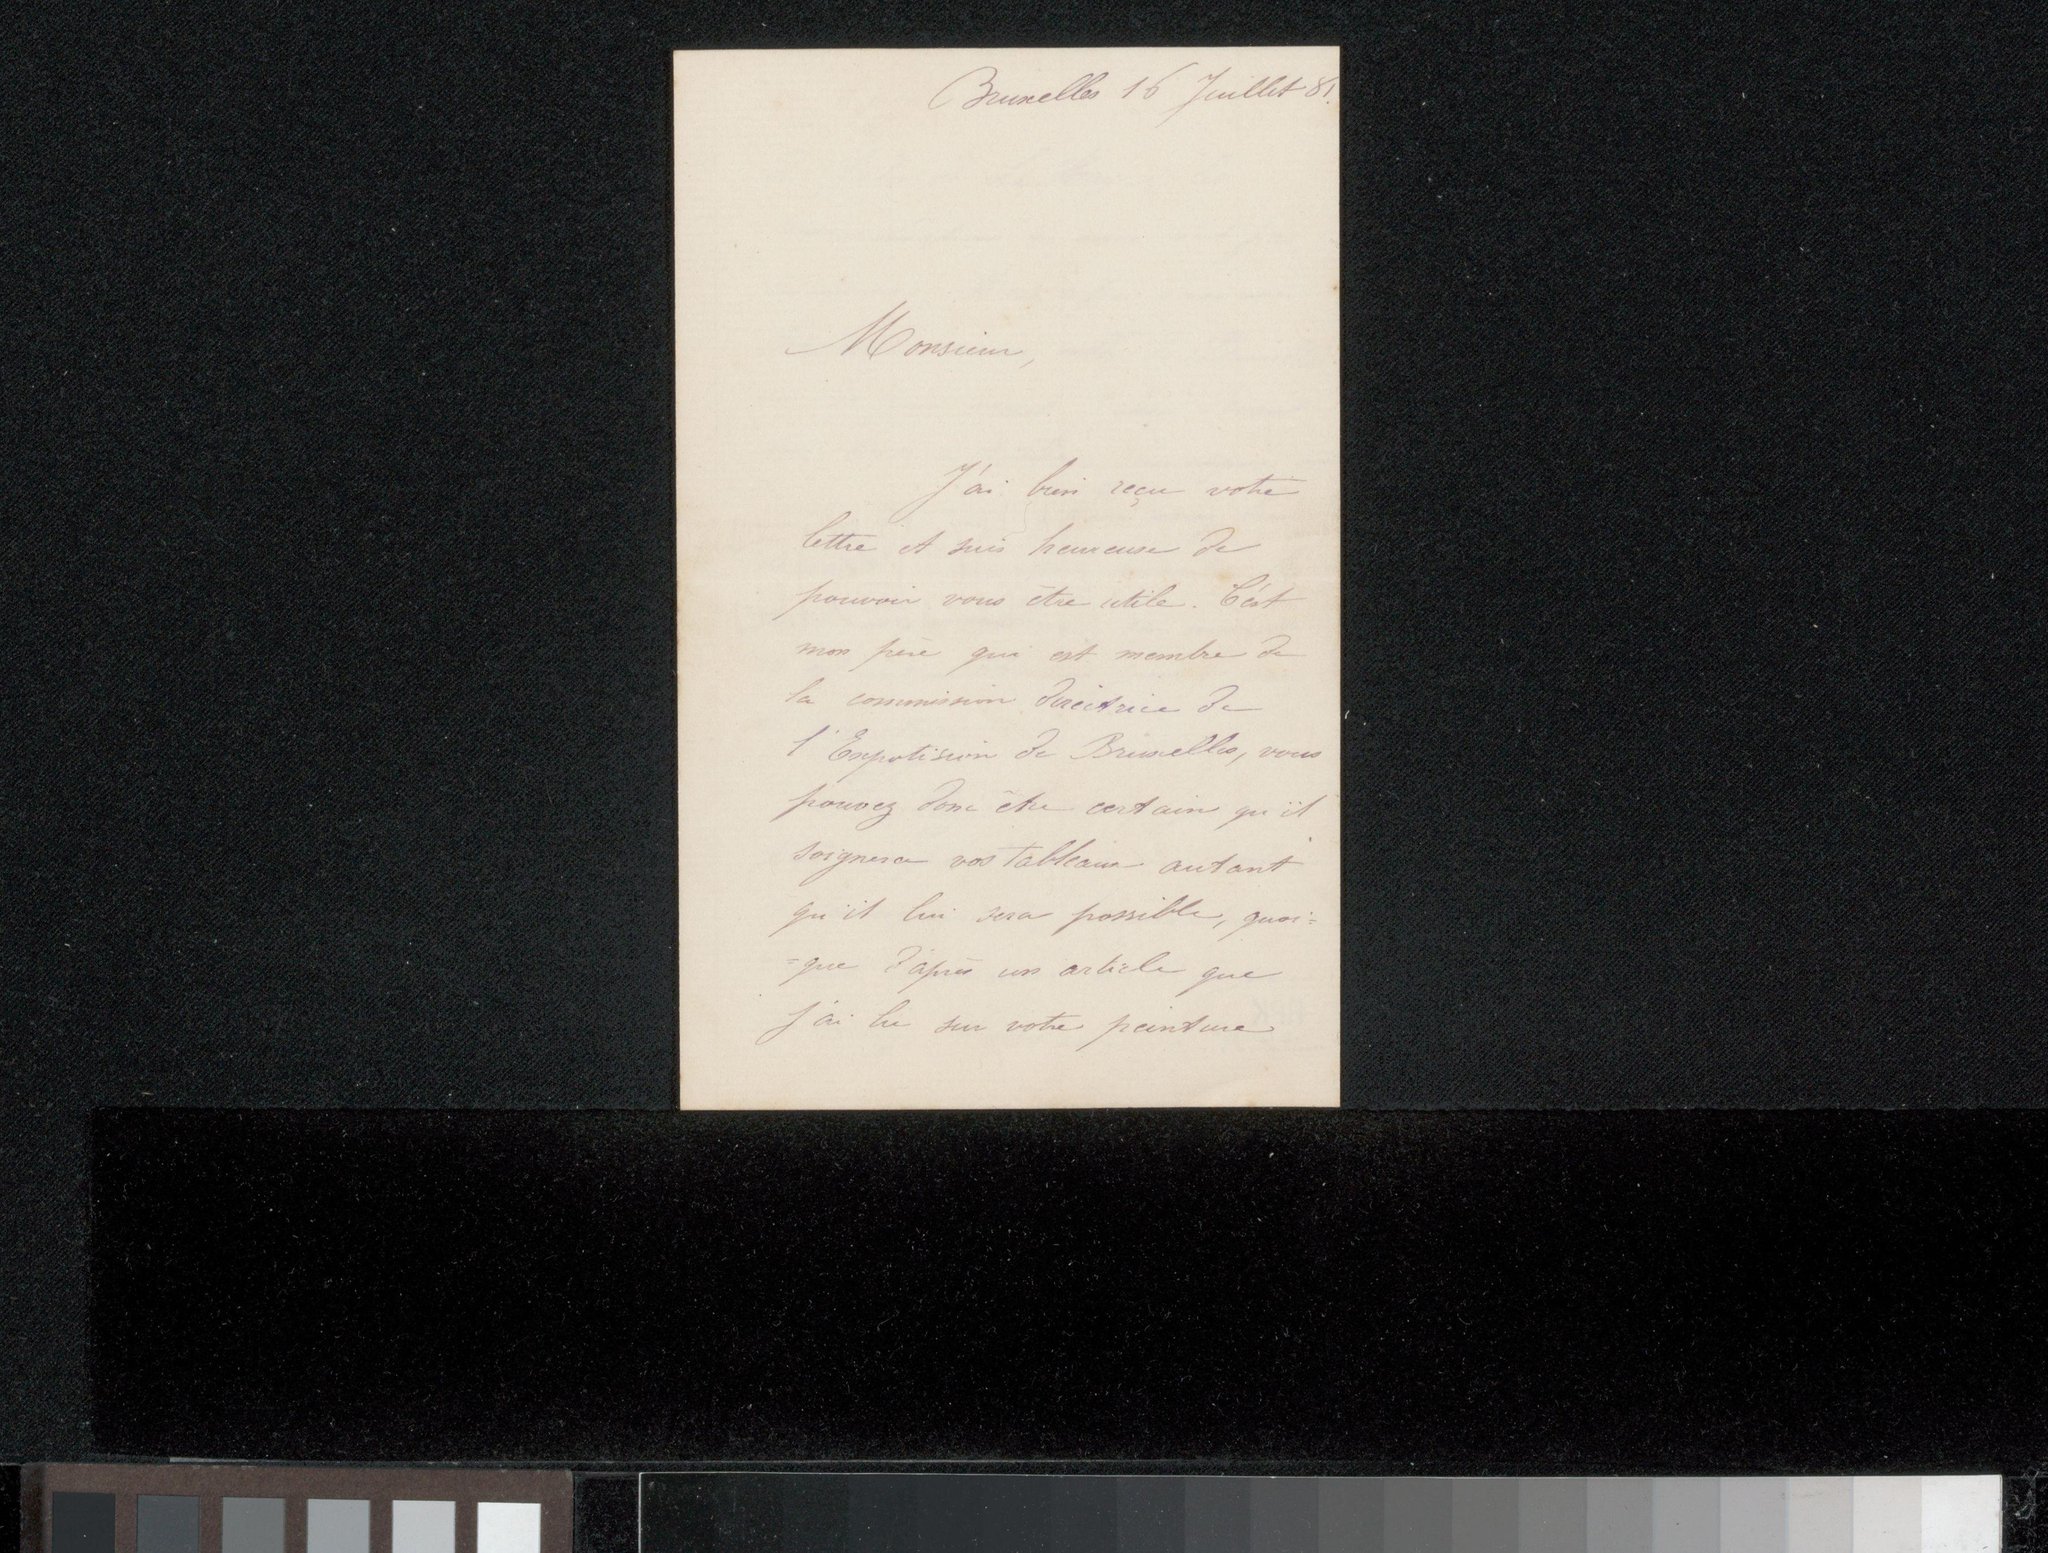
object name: letter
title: Brief aan Philip Zilcken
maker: georgette meunier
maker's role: painter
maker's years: 1859-1951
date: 1881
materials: ink, paper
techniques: pen, writing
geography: brussels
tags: the hague, painter, draughtsman, philip zilcken, painting (including book-illumination, miniature-painting), exhibition ~ art, brussels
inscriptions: collector's mark: ‘RPK’, watermark